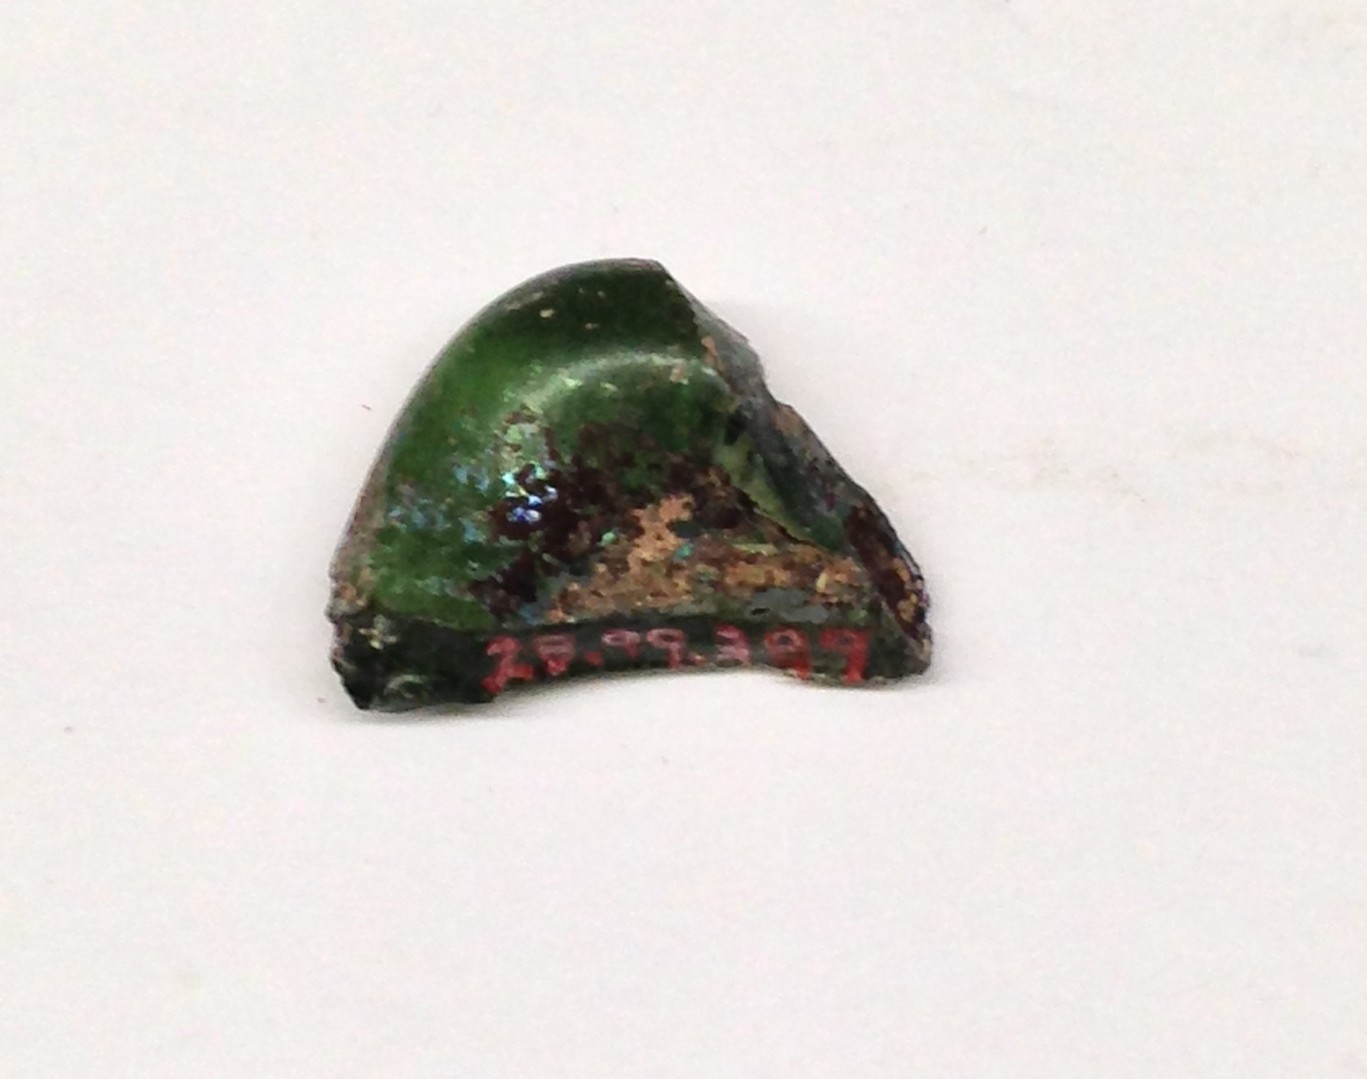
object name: fragment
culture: european or middle eastern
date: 1150-1250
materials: ceramic, glass